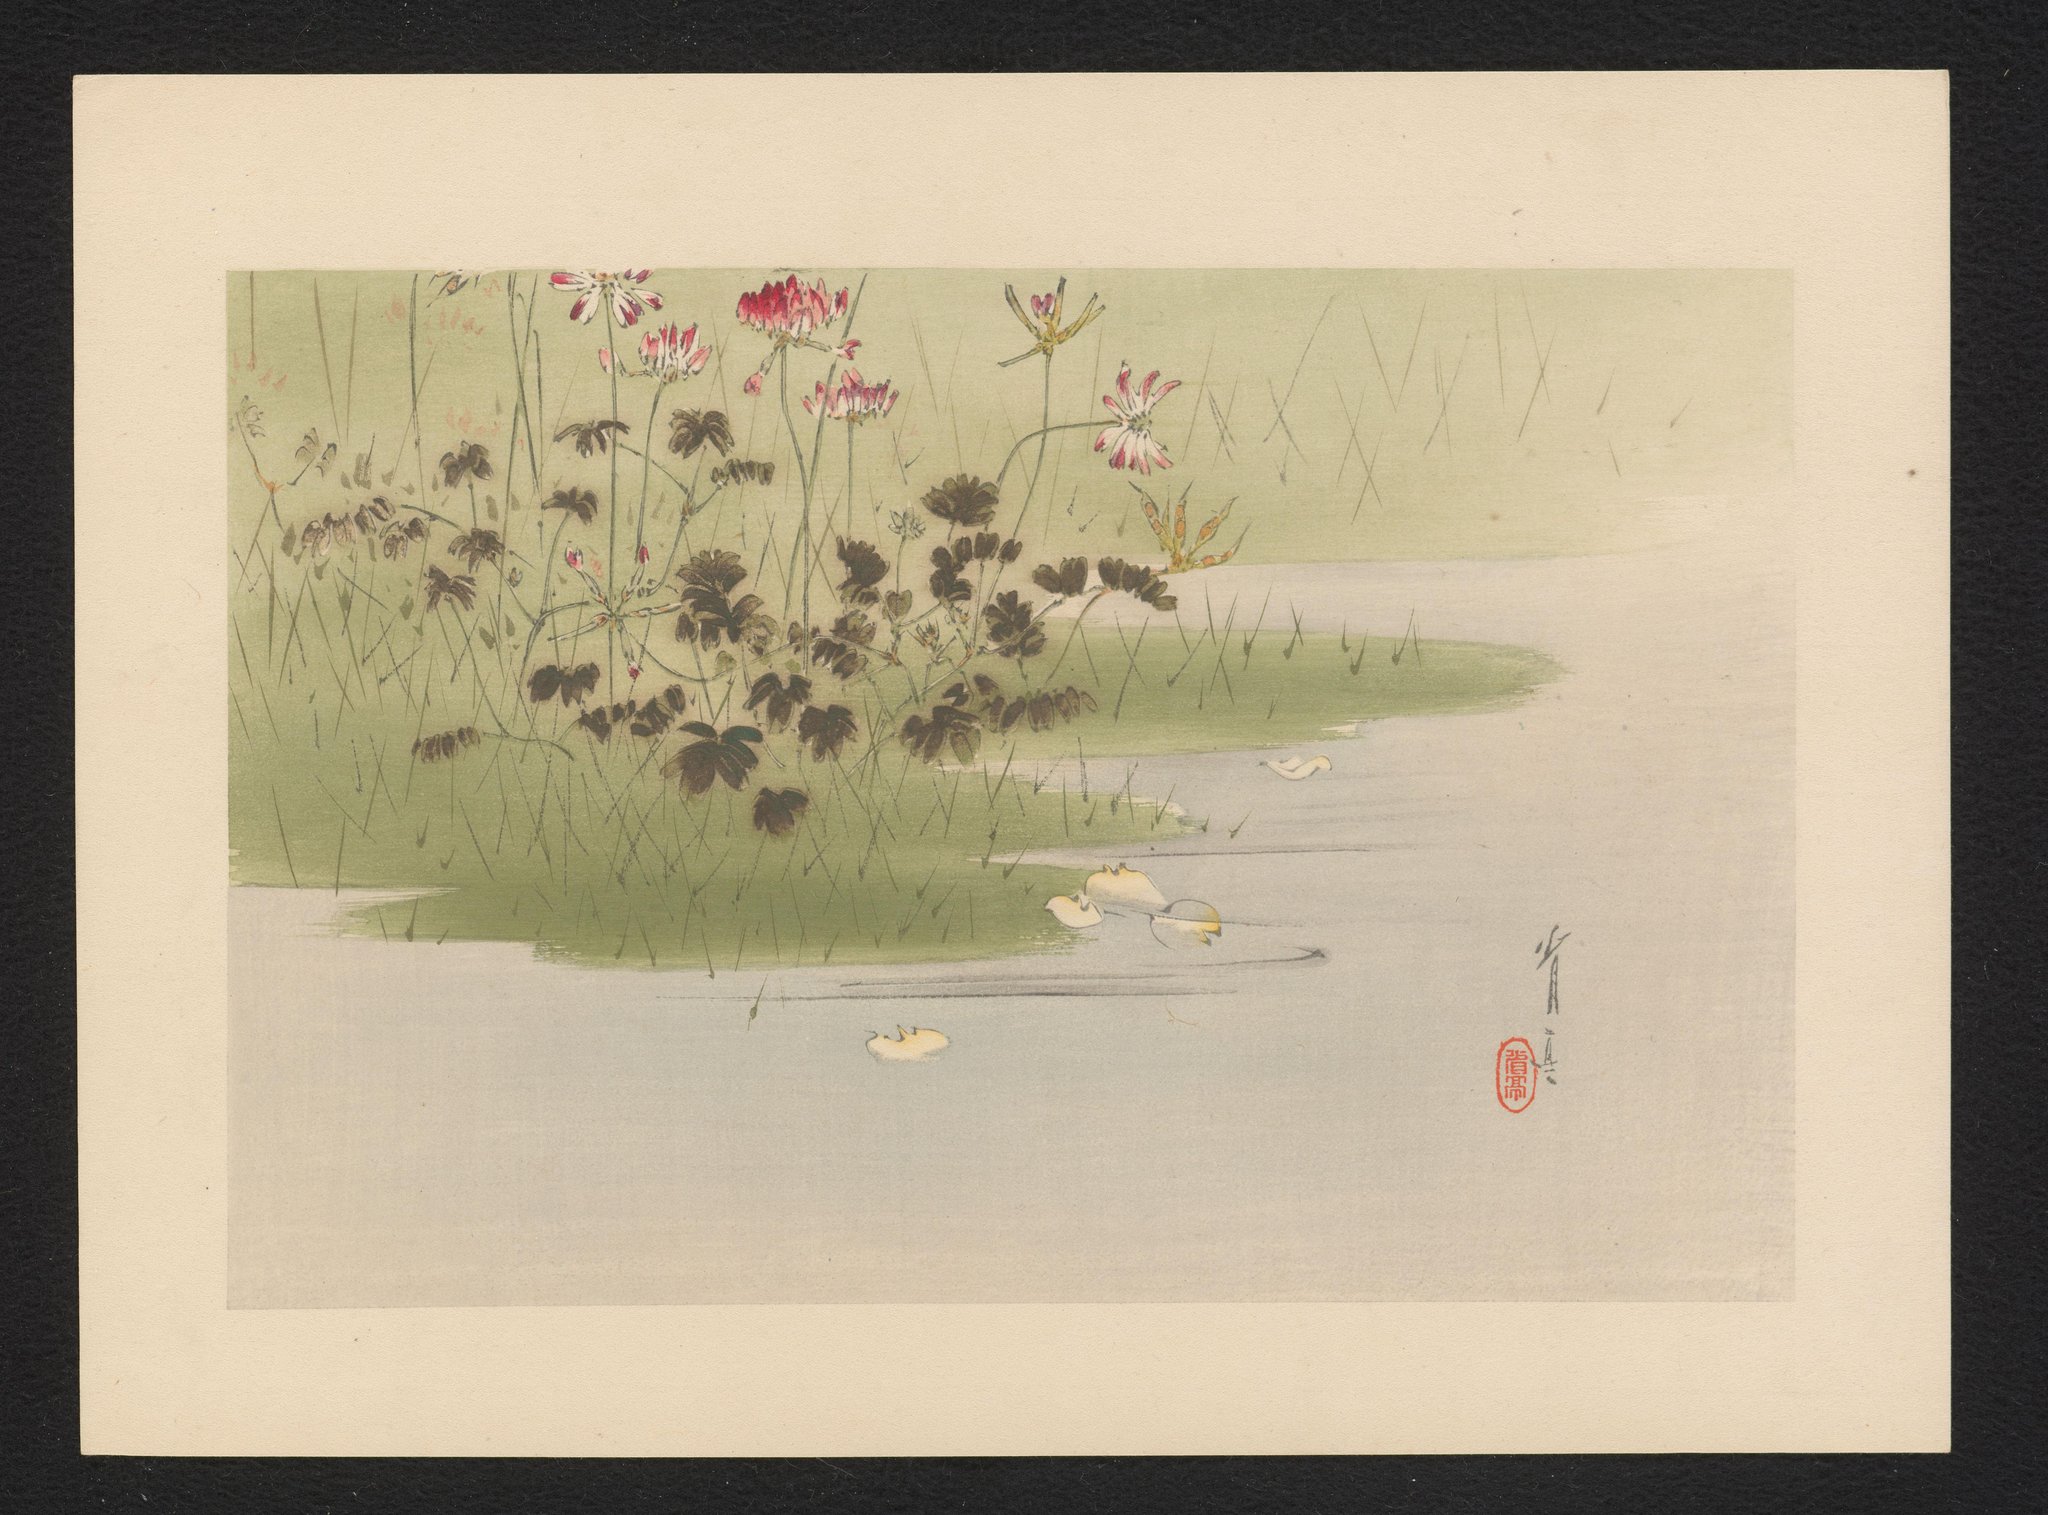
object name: print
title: Seitei kacho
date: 1916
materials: paper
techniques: woodcut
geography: tokyo